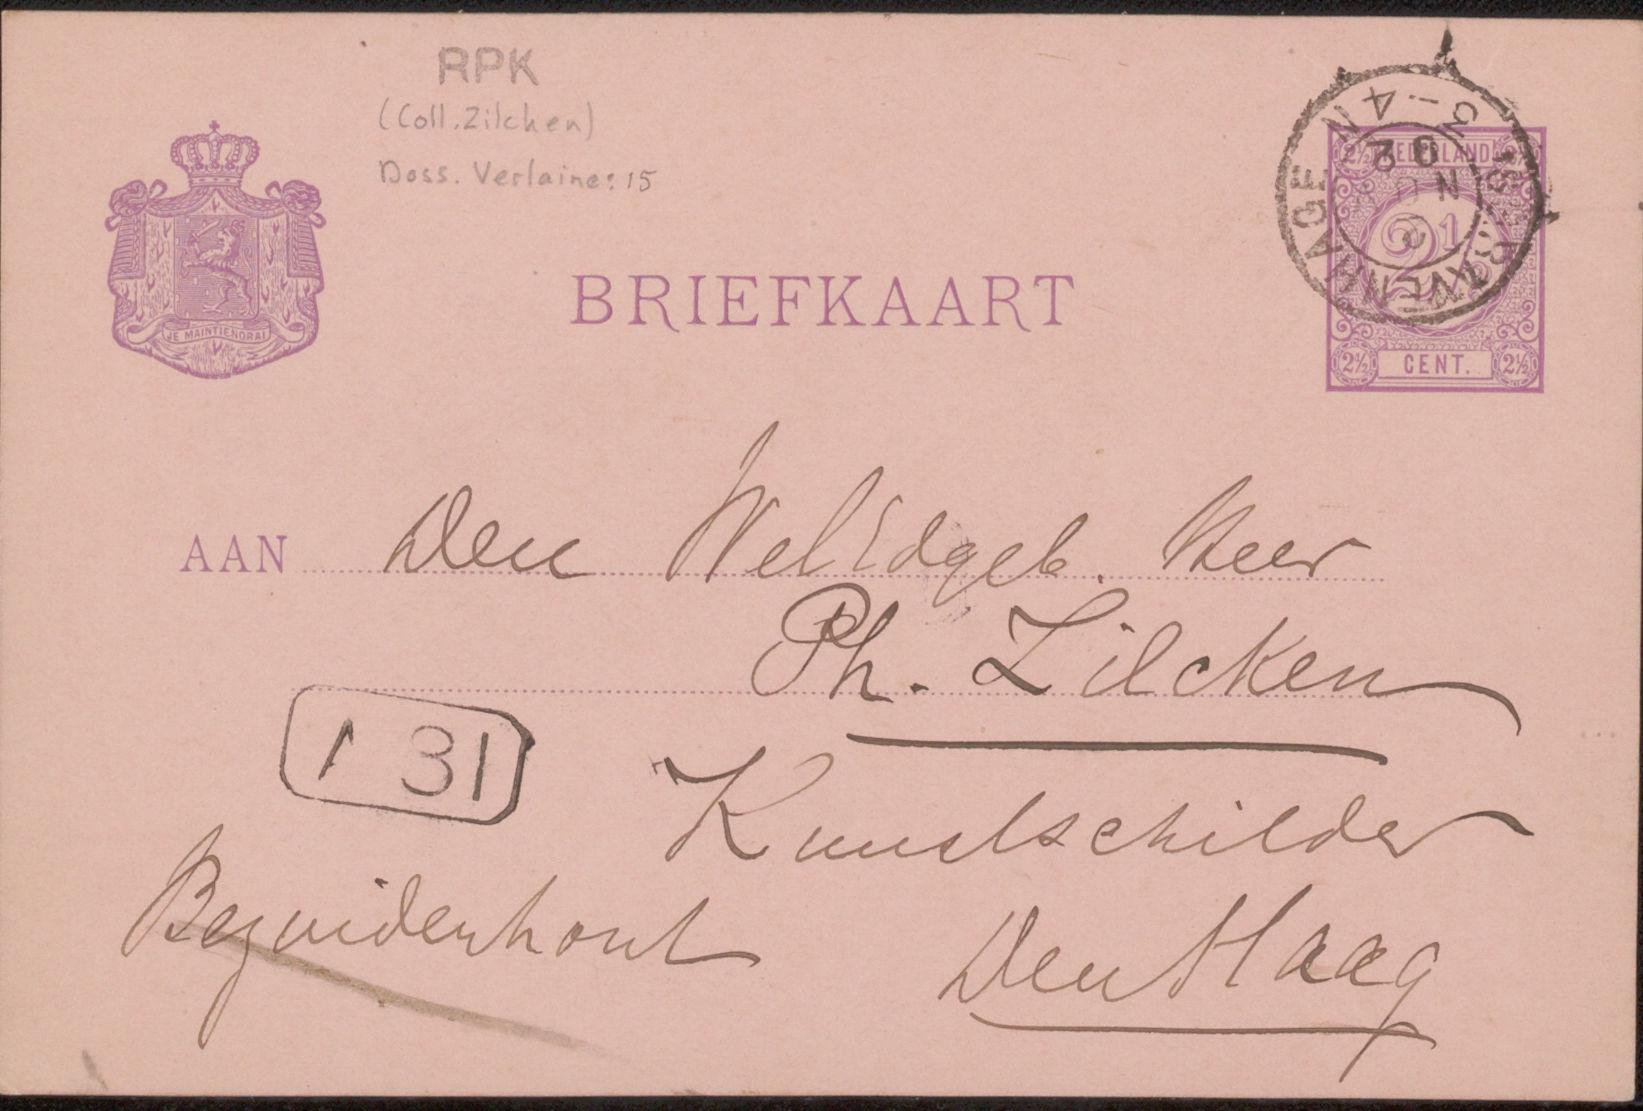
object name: postcard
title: Briefkaart aan Philip Zilcken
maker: Anonymous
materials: cardboard, ink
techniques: pen, writing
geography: the hague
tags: paul verlaine, the hague, painter, draughtsman, philip zilcken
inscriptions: collector's mark: ‘RPK’